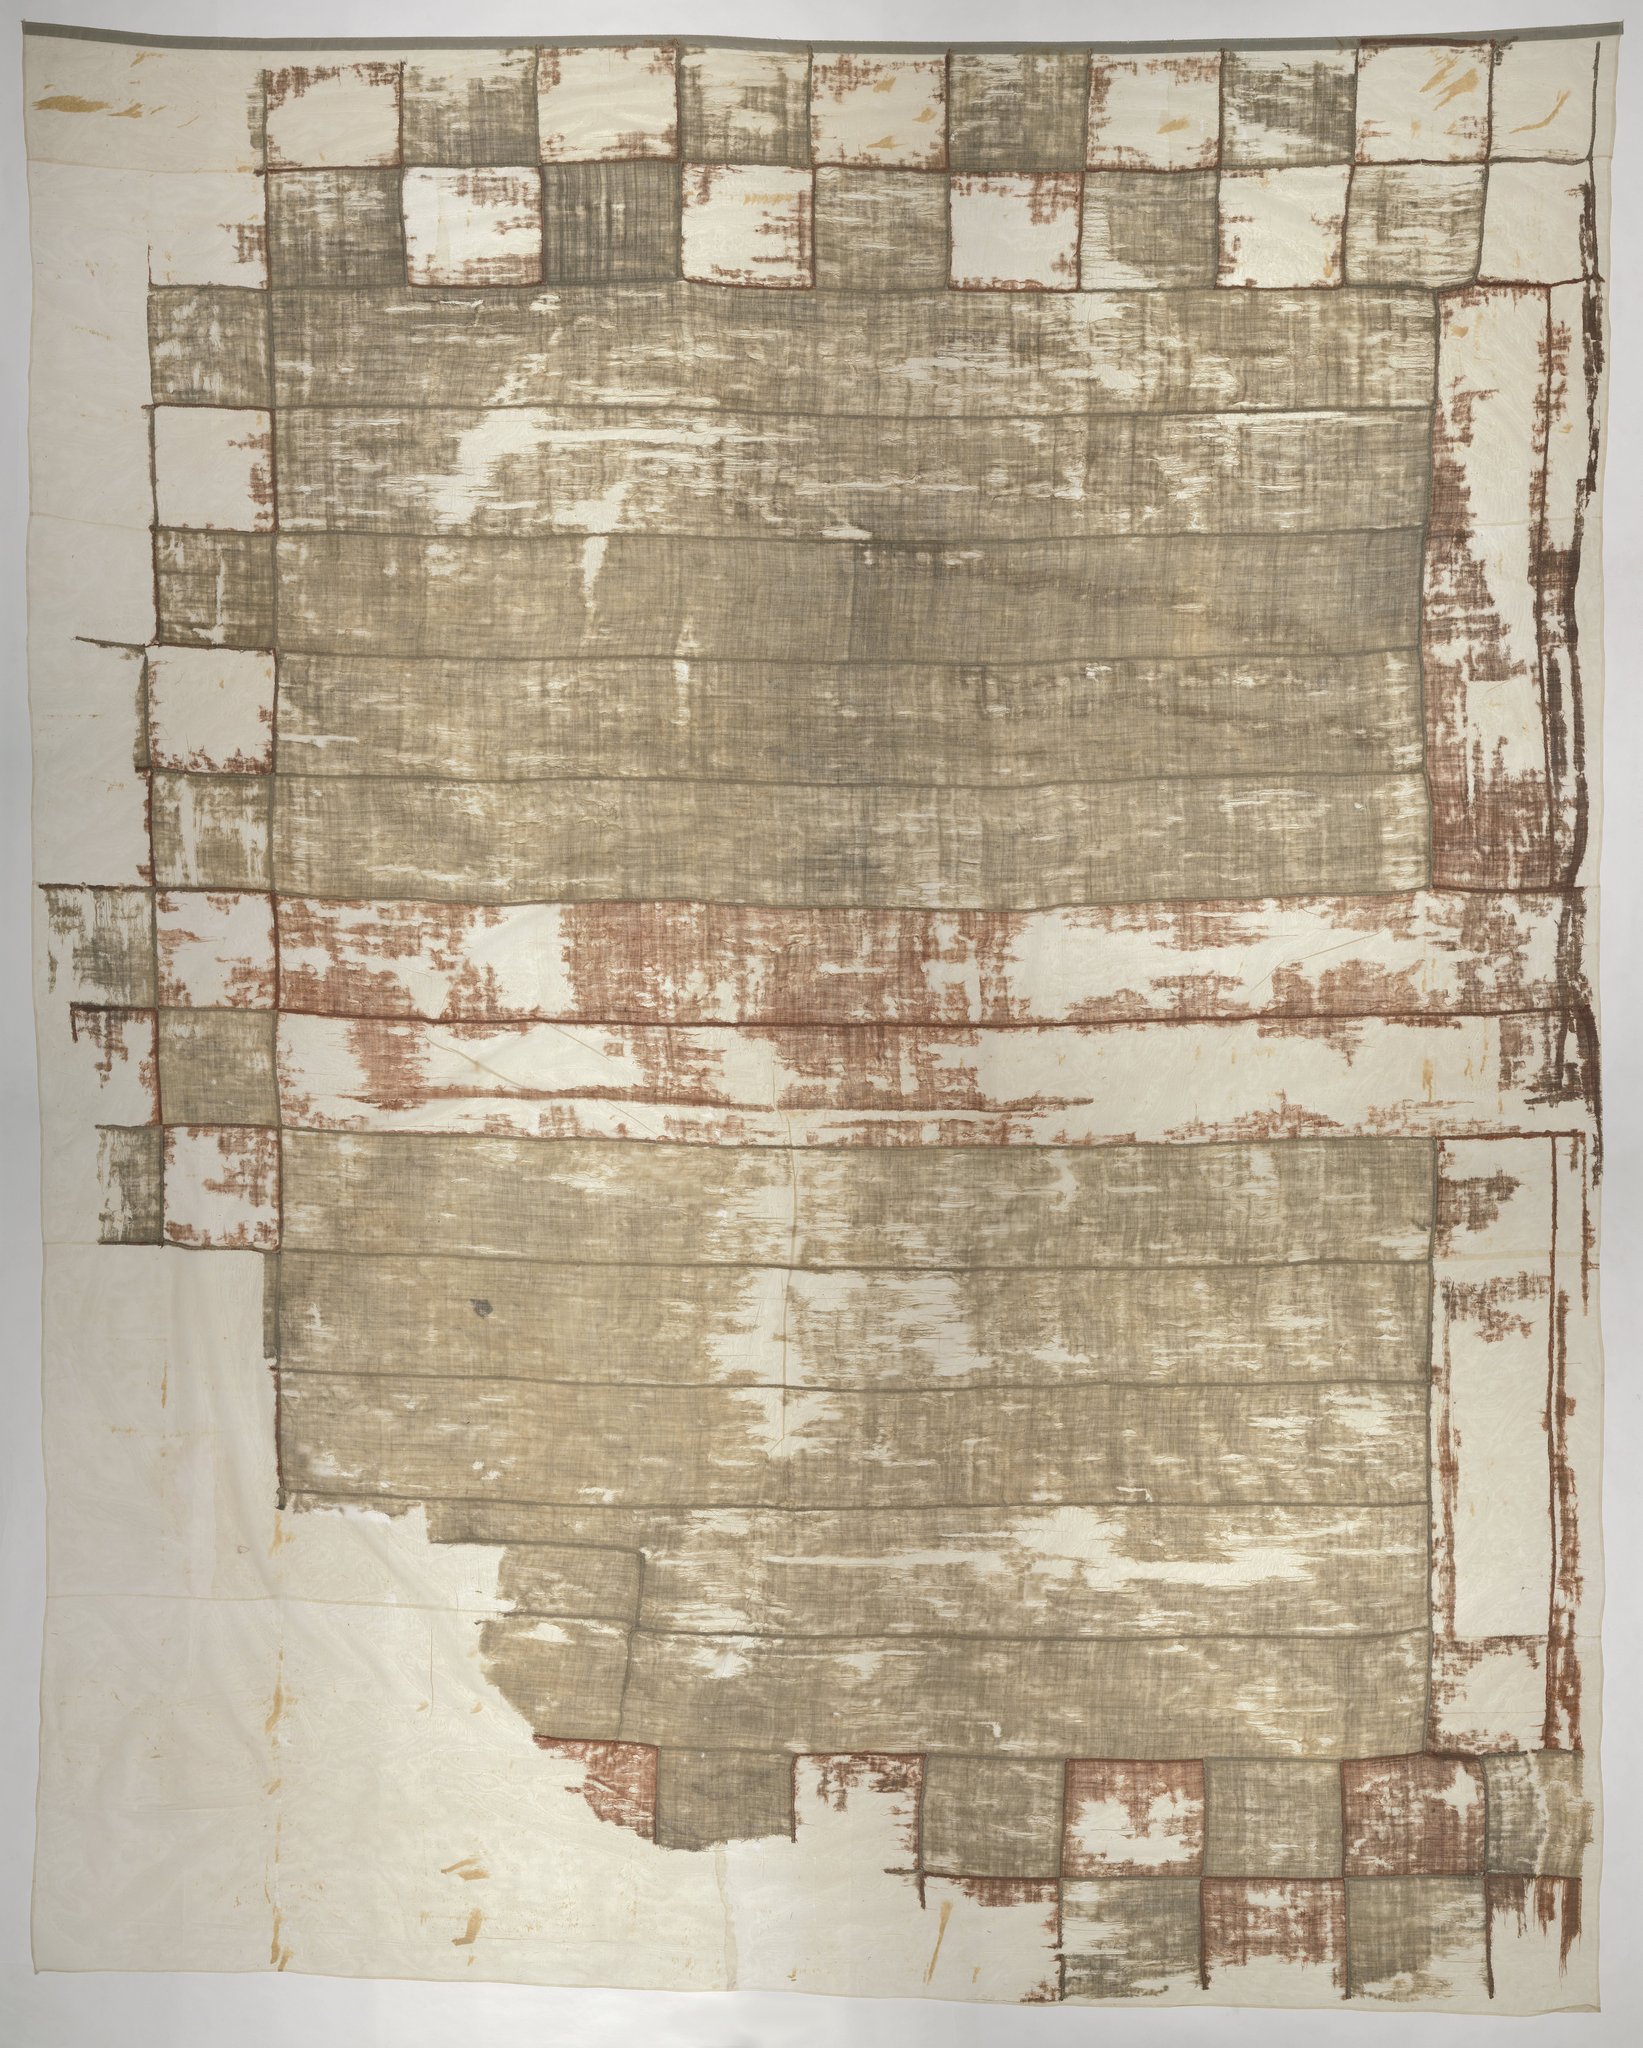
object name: ship flag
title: Fragment of a Ship Flag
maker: Anonymous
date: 1665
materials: wool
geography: england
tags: flag, colours (as symbol of the state, etc.)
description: Fragment van een scheepsvlag, bijna de gehele linker helft, met een rood kruis (St. George's cross) op een witte achtergrond, en een dubbele rood-wit geblokte rand. Deze vlag is een 'Guinea Jack', die door de Engelse Royal Africa Company werd gevoerd. Dit exemplaar is waarschijnlijk in 1665 veroverd van het fort Cormantijn op de kust van West Afrika.